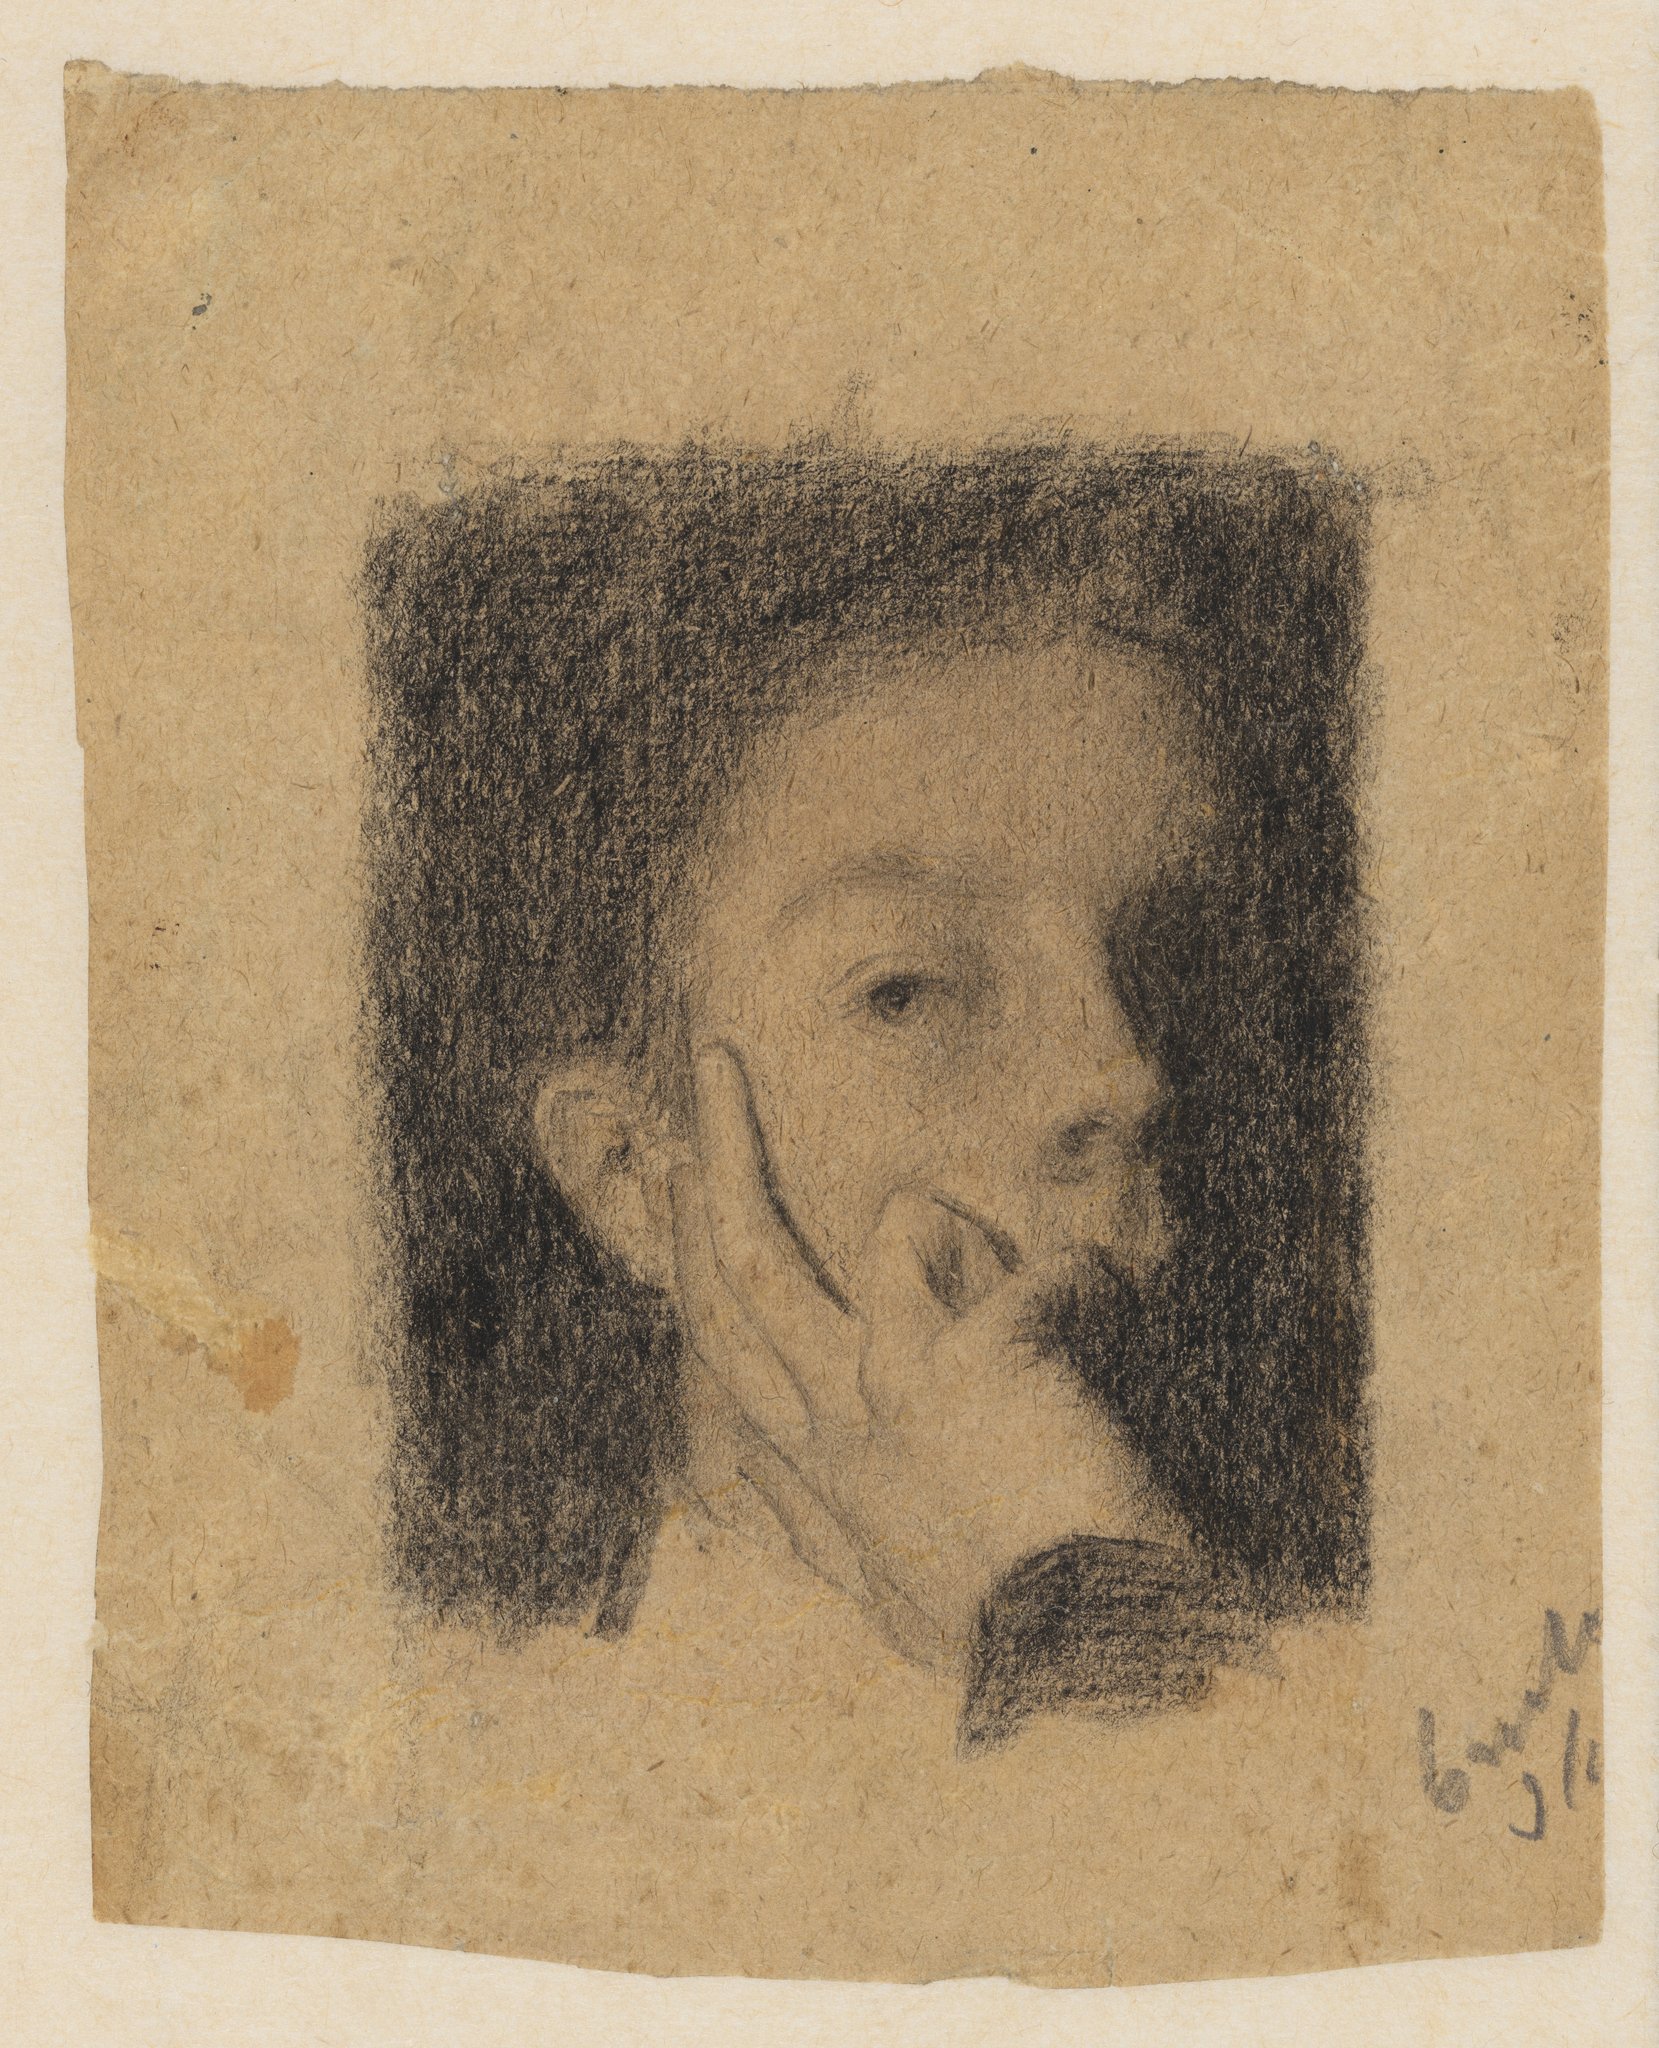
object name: drawing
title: Self-Portrait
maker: henri fantin-latour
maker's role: artist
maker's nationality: french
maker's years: 1836-1904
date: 1854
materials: chalk